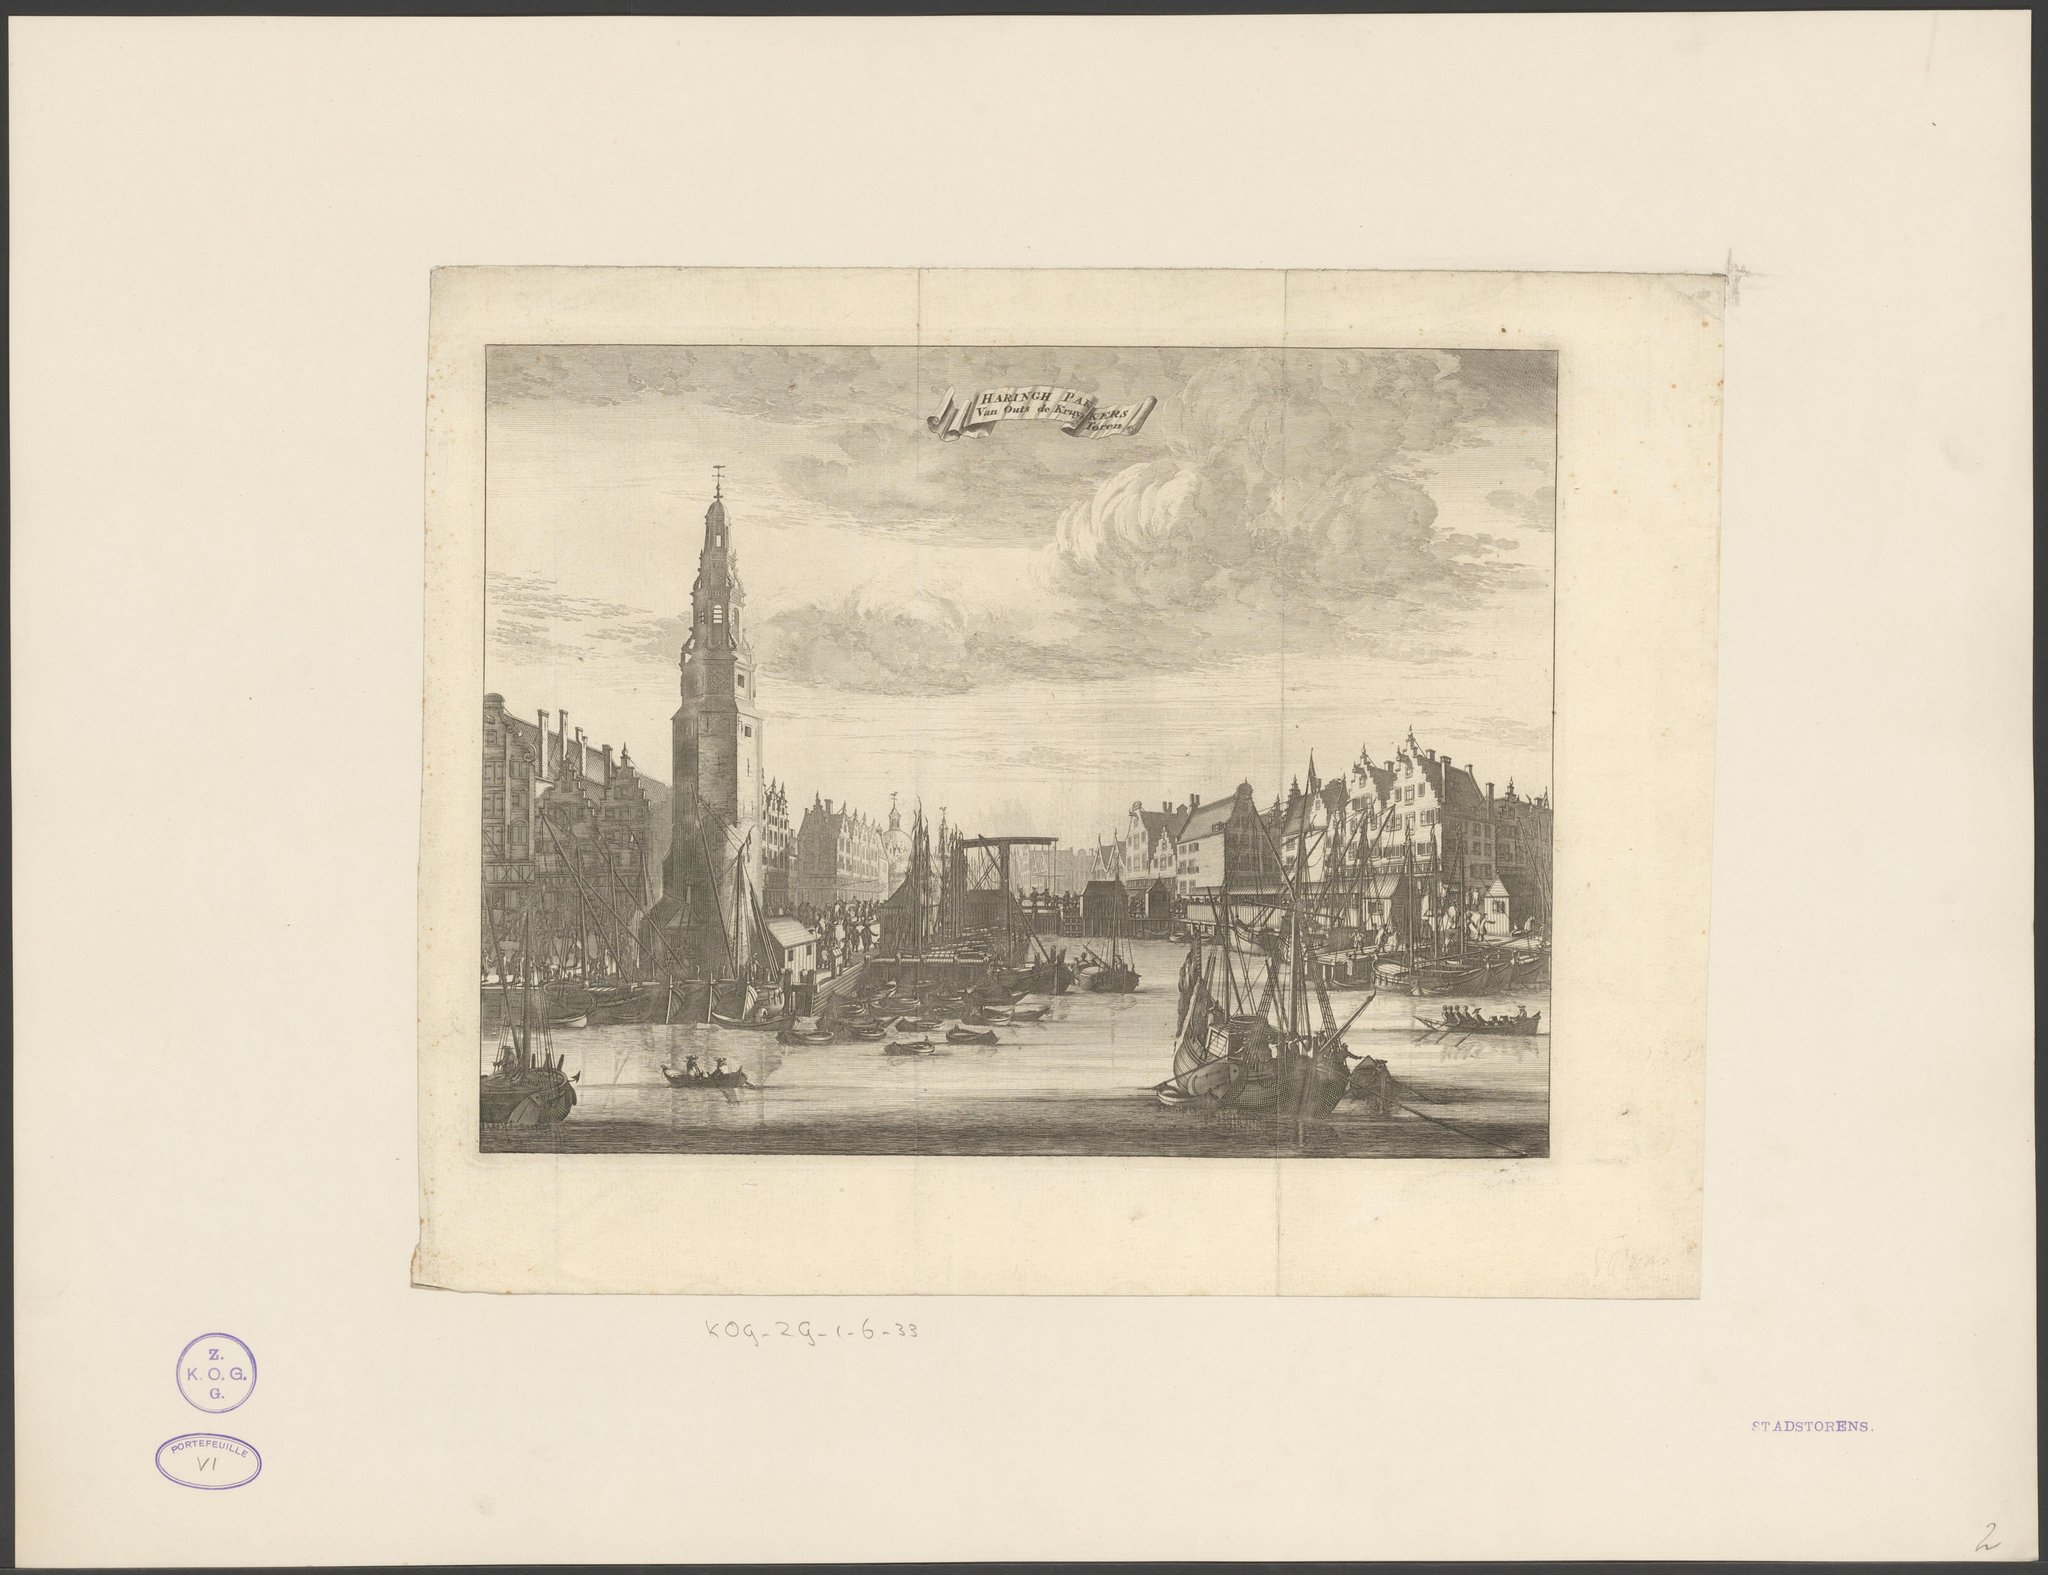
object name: print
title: Haringh Pakkers Van Outs de Kruys Toren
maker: Anonymous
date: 1724-1726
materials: paper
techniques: engraving, etching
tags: towers ~ fortified city, canal, bridge, city-gate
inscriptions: collector's mark: Lugt 1641, stamp, stamp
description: Prent mogelijk uit: Commelin, Caspar. Beschryvinge van Amsterdam, zynde een naukeurige verhandelinge van desselfs eerste oorspronk uyt (…). 2 dln. 2de druk. Amsterdam: Andries van Damme et al., 1726.